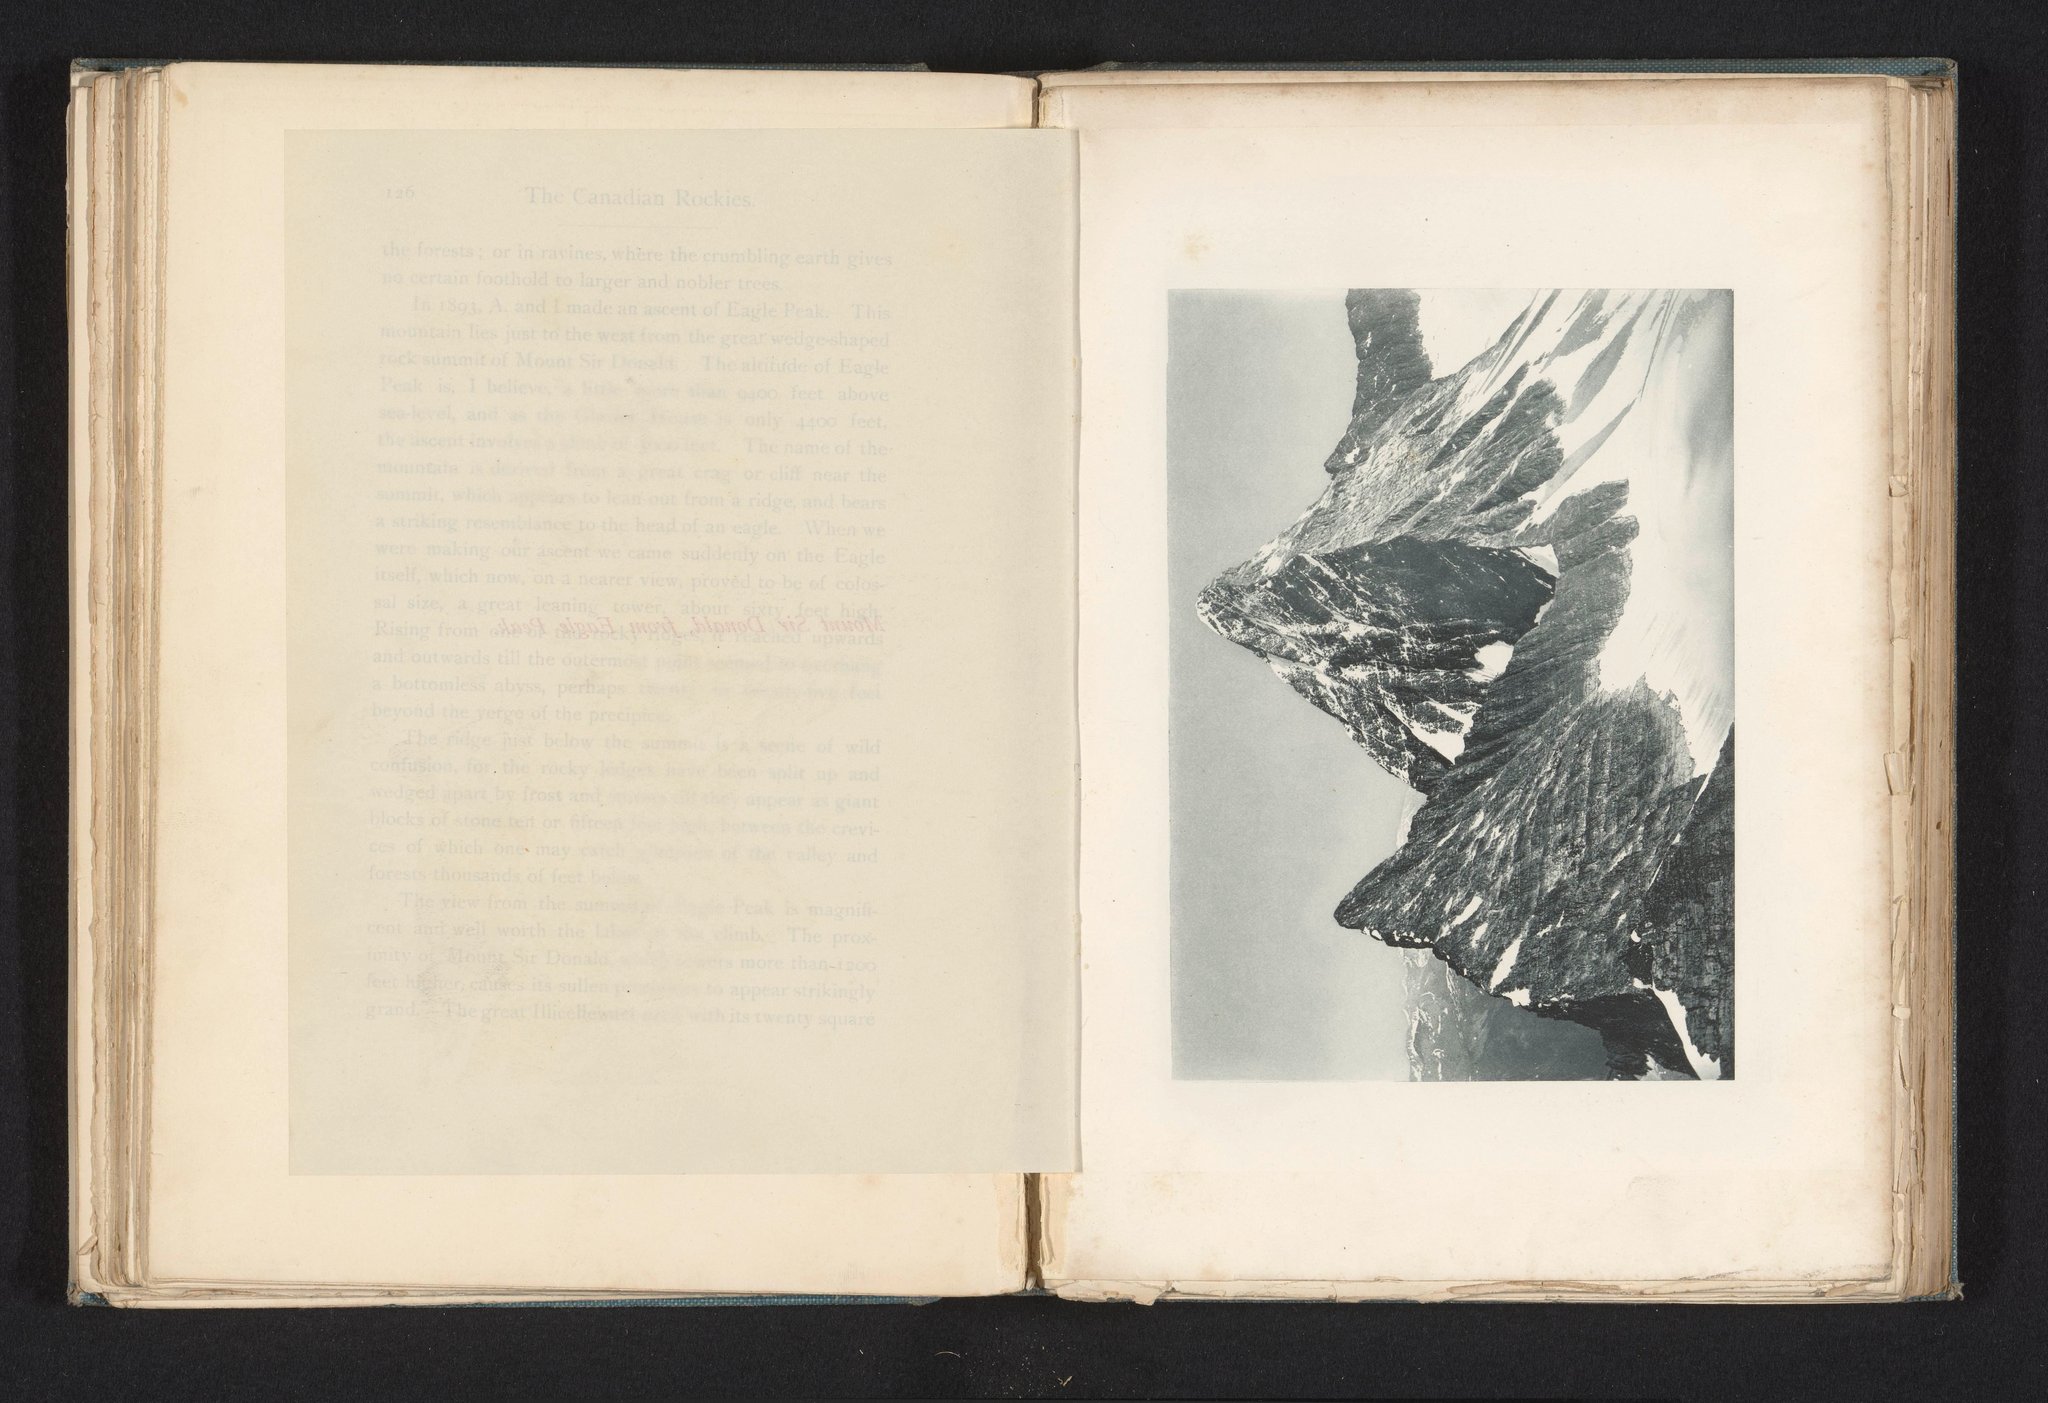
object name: page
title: Gezicht op Mount Sir Donald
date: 1893-1897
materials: paper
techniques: photoaquatint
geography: british columbia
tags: mountain-top, peak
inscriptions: title: ‘Mount Sir Donald from Eagle Peak’